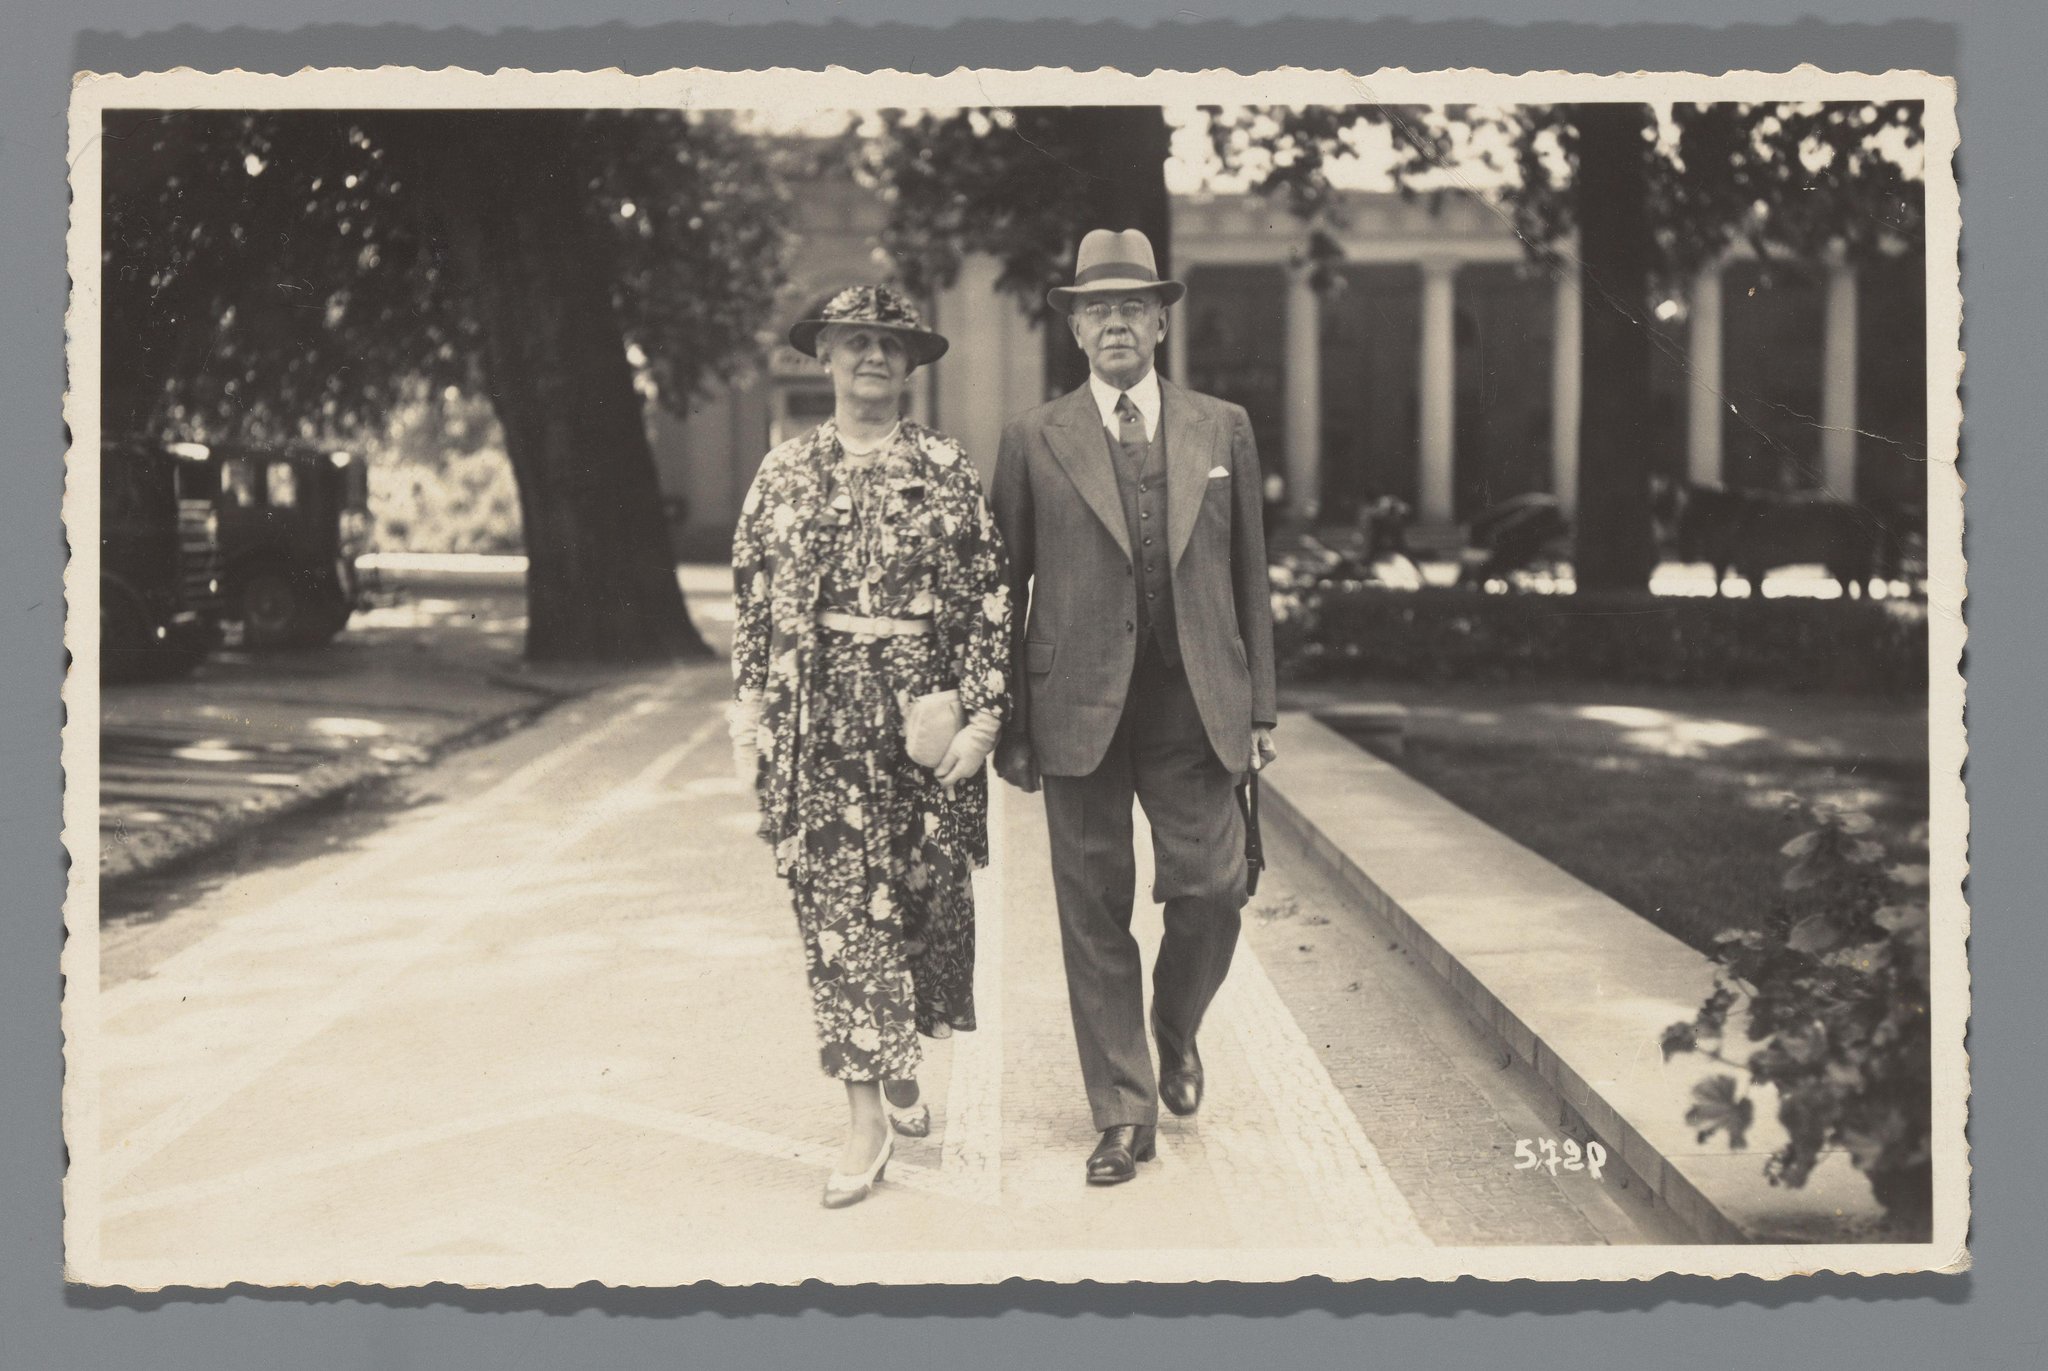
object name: ansichtkaart, prentbriefkaart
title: Portret van Line en Hendrik Herman van den Berg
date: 1937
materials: photographic support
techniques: photography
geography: wiesbaden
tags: hendrik herman van den berg, the hague, caroline louise van den berg-van den berg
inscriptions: seal, number: ‘5729’, stamp, inscription, name: ‘Foto Kukuk, Wiesbaden, Wilhelmstrasse 55 Tel. 21...’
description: Line en Hendrik Herman van den Berg wandelend in Wiesbaden.